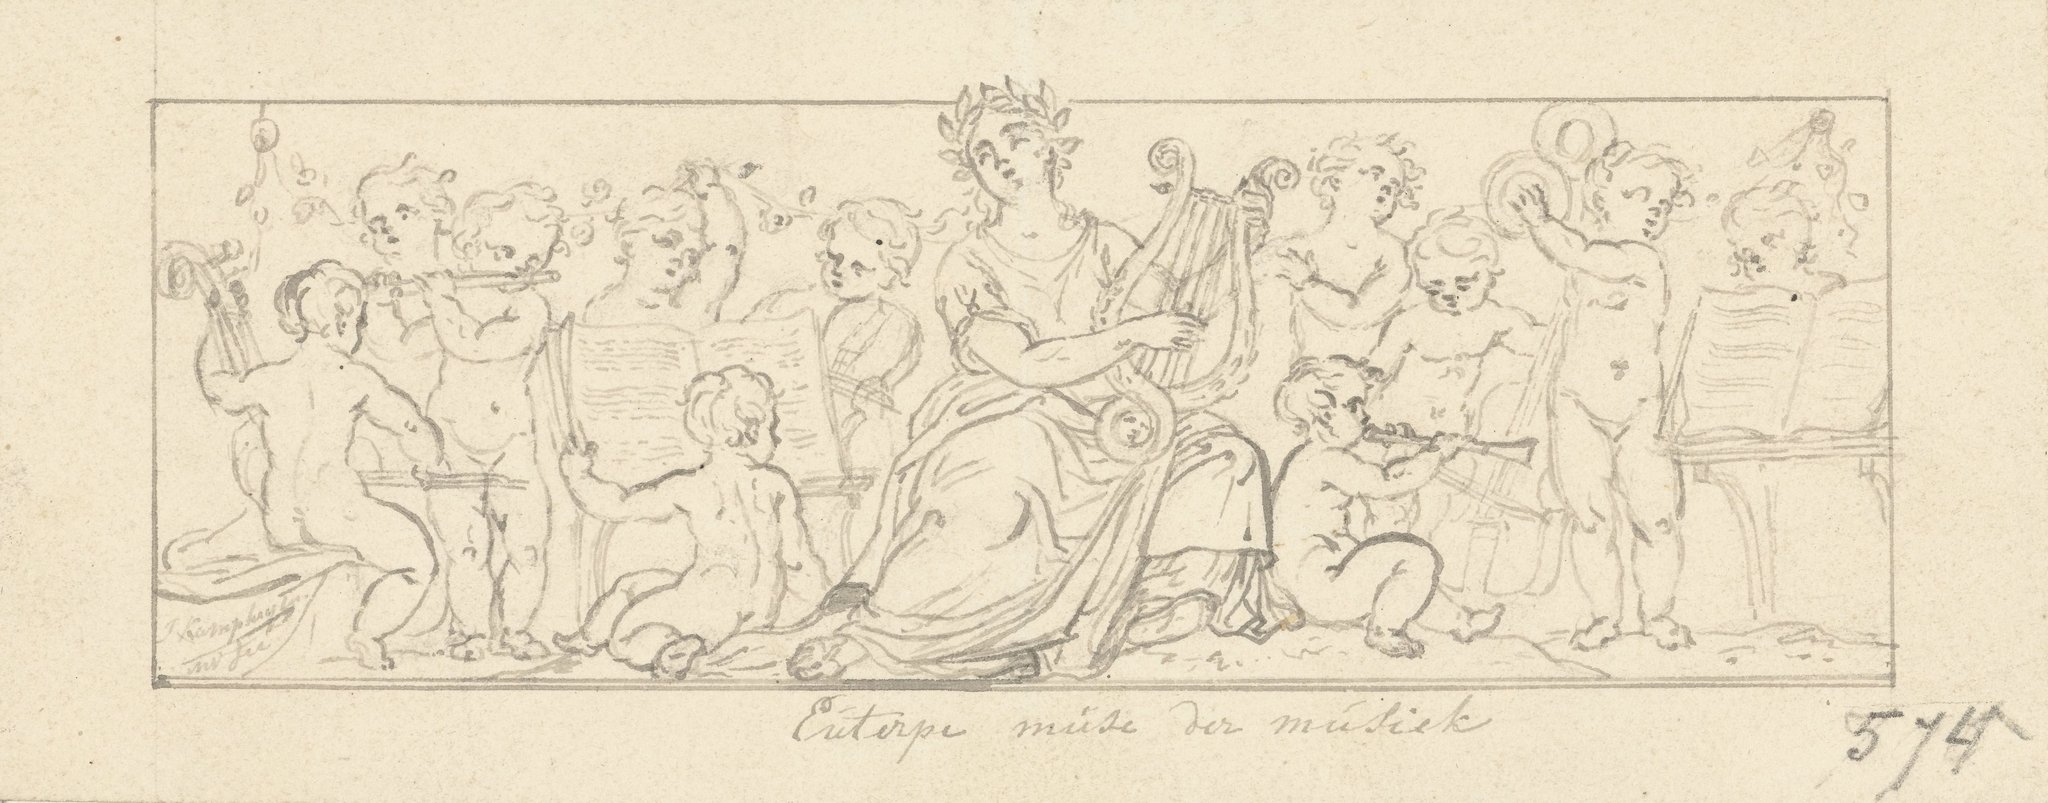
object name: drawing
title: Euterpe, de muze van de Muziek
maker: jan kamphuijsen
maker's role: draughtsman, painter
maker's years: 1760-1841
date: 1770-1841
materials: ink, paper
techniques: pen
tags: euterpe (one of the muses); 'euterpe' (ripa)